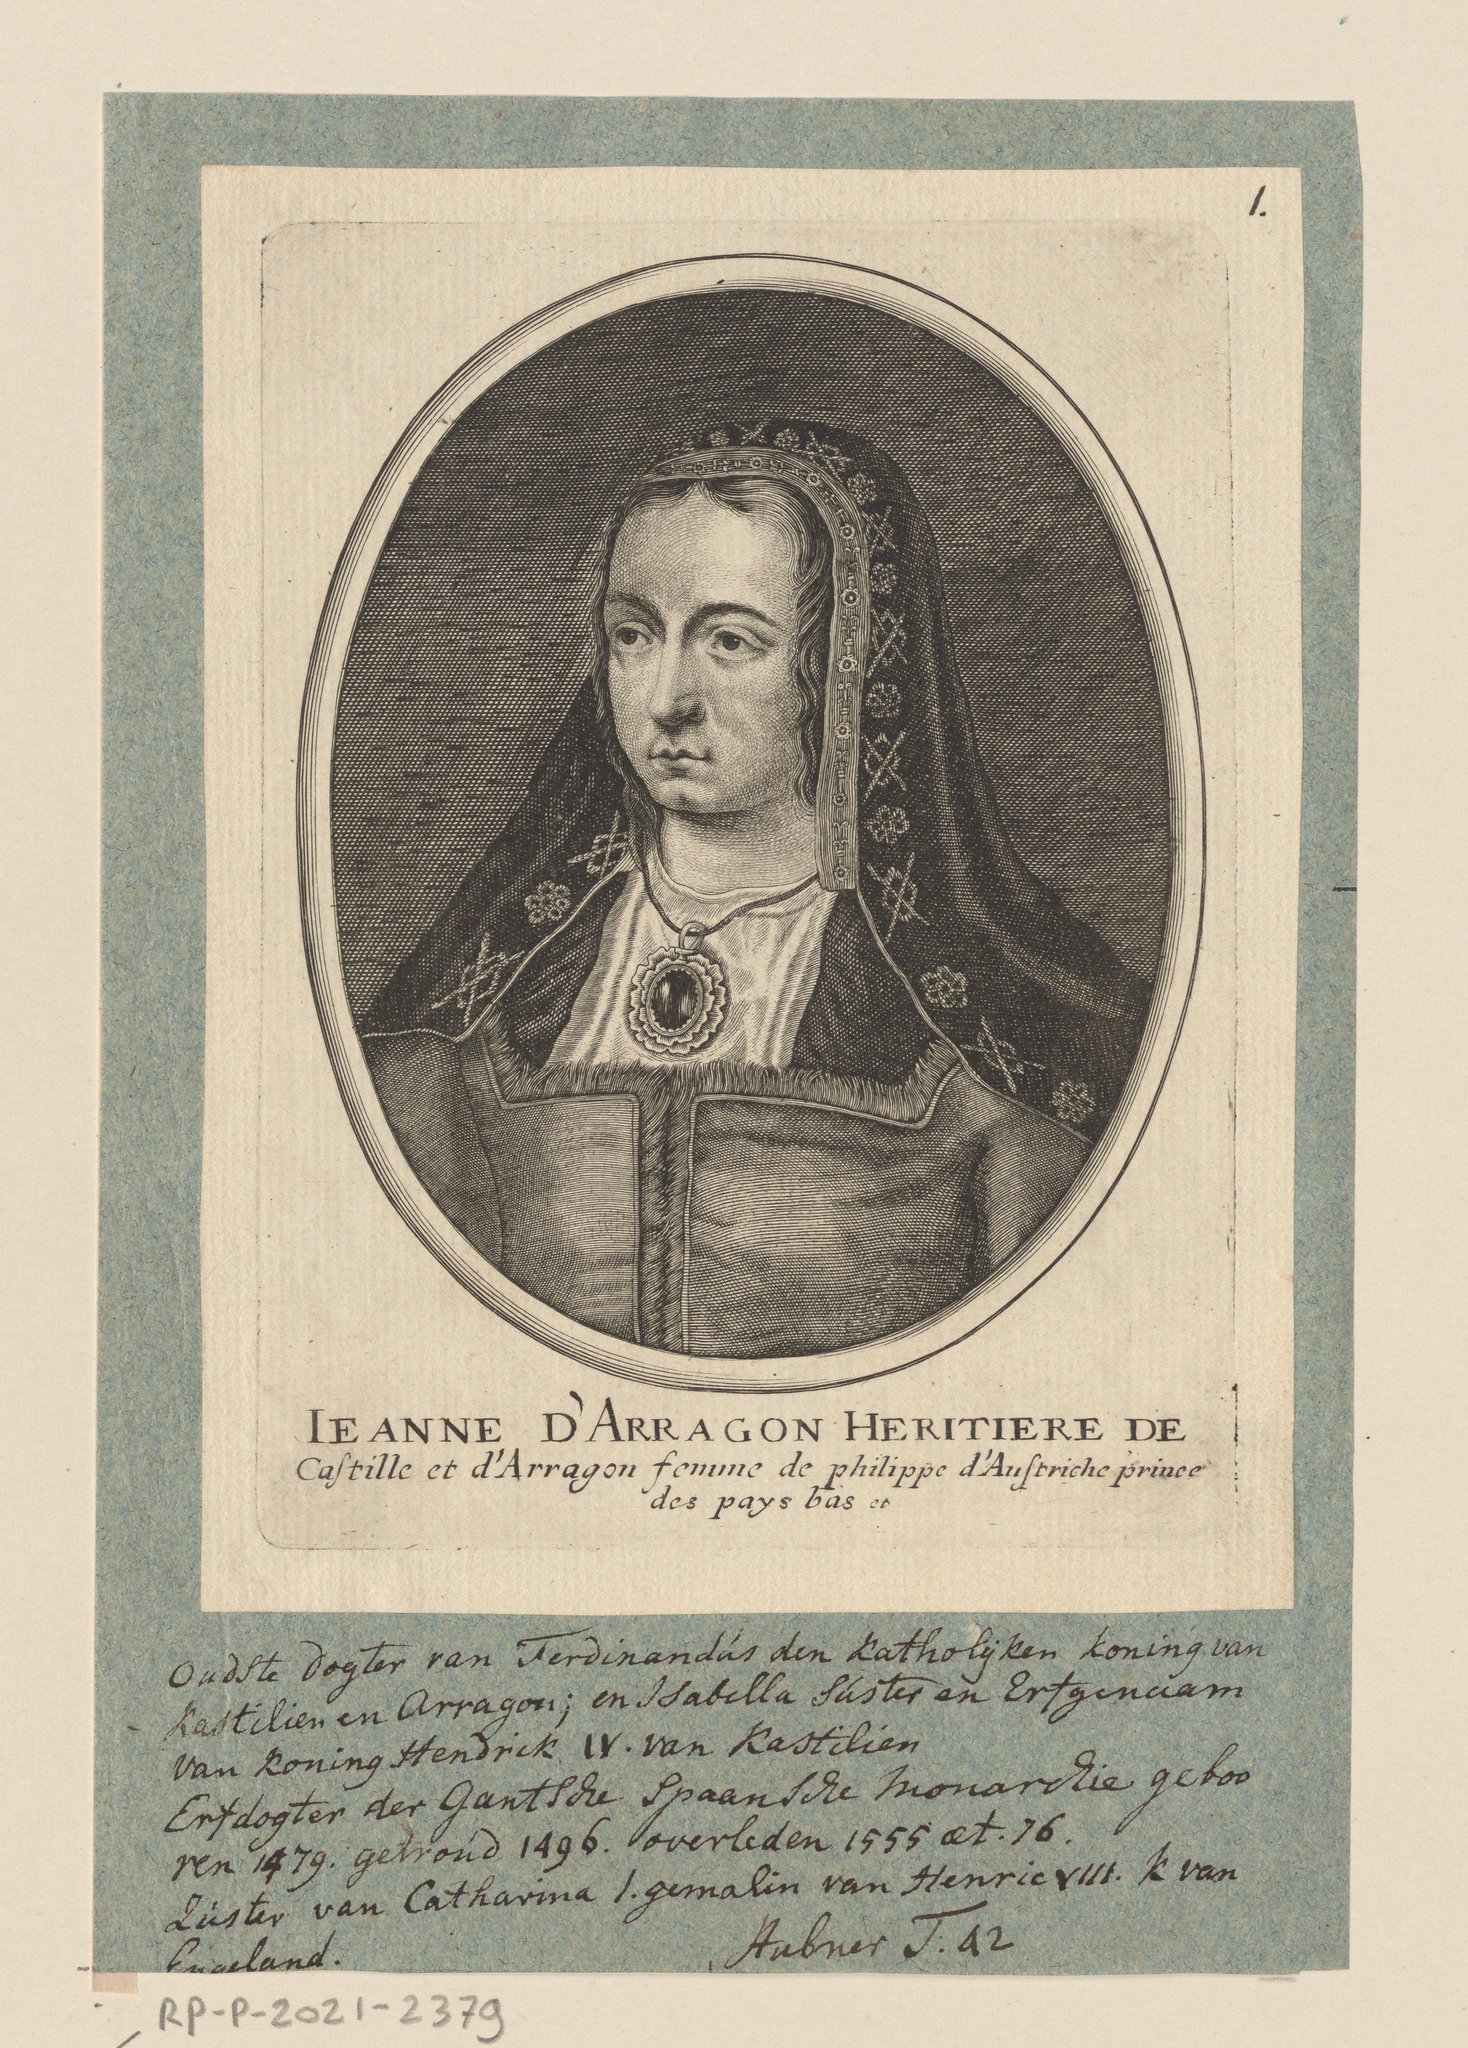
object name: print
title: Portret van Johanna van Castilië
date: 1652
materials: paper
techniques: engraving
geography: paris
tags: historical persons - bb - woman, queen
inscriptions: inscription: ‘1.’, inscription: ‘Oudste dogter van Ferdinandus den Katholijken koning van/ Kastilien en Arragon (...)’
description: De prent vertoont stilistische overeenkomsten met de serie portretten uitgegeven door Moncornet, bekend onder 'Recueil de portraits des rois, princes et seigneurs français et étrangers', ca. 1652.